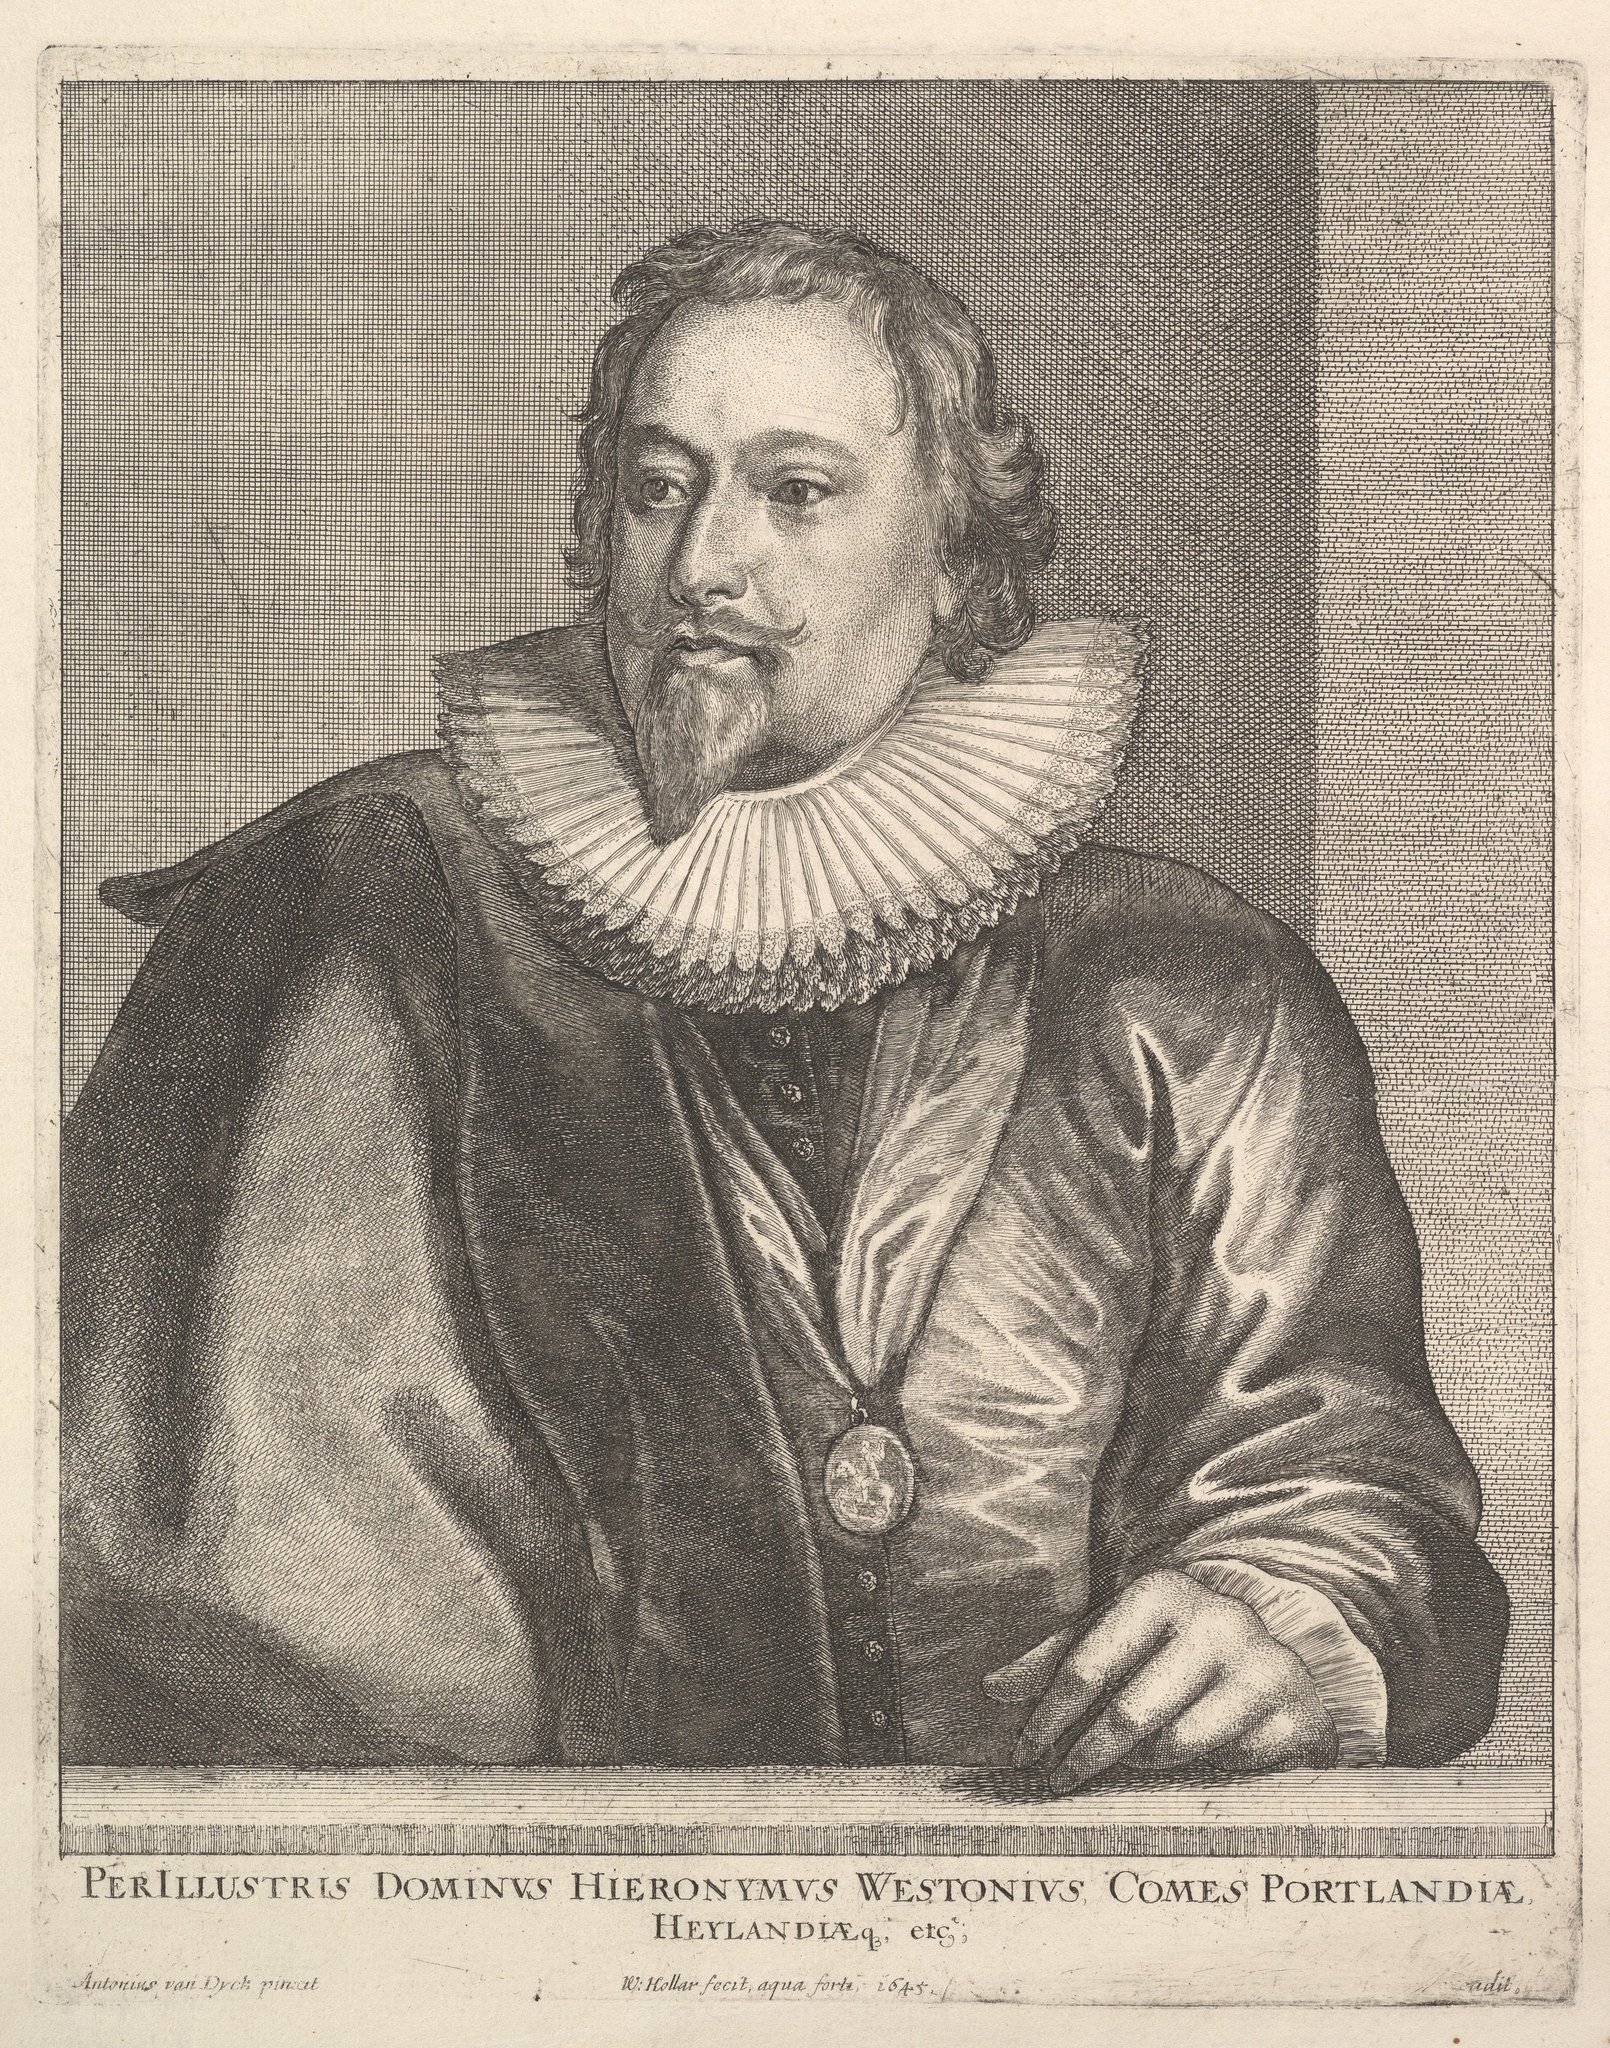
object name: print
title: Hieronymus Westonius (Richard Weston, Earl of Portland)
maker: wenceslaus hollar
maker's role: artist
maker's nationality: bohemian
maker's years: 1607-1677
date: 1645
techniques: etching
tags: men,portraits